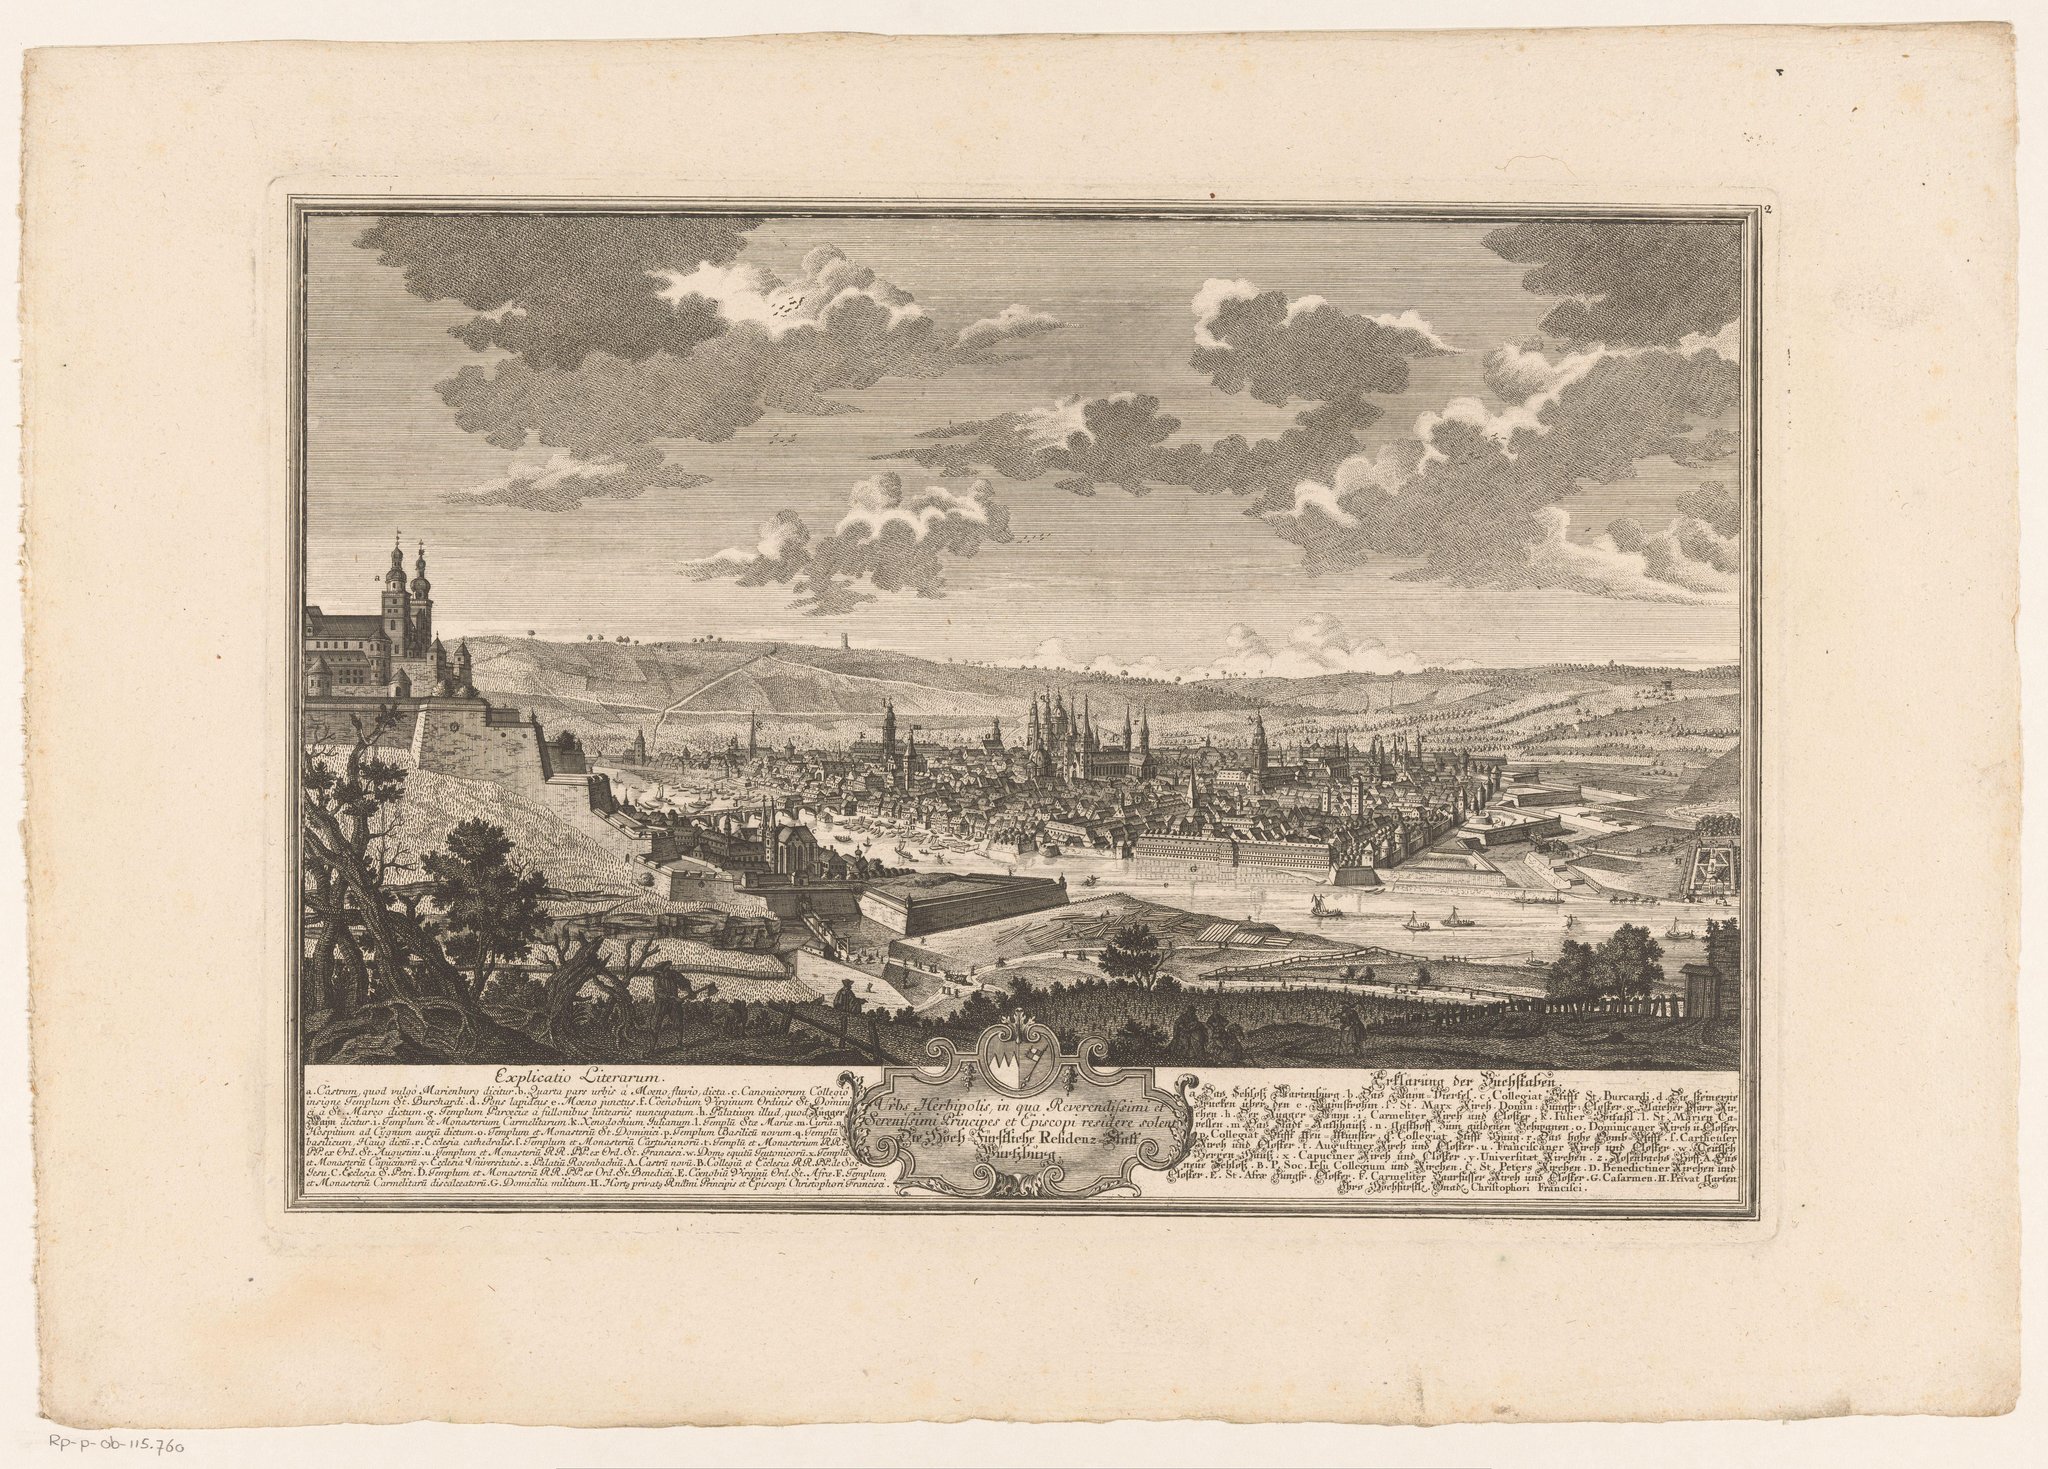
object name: print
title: Gezicht op Würzburg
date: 1740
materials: paper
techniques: etching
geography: augsburg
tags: city-view, and landscape with man-made constructions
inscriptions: collector's mark: Lugt 2228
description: Serie bestaande uit elf prenten plus een titelprent. Johann Andreas Pfeffel wordt op de titelprent aangeduid als prentmaker, maar zijn naam staat op de prenten niet vermeld.